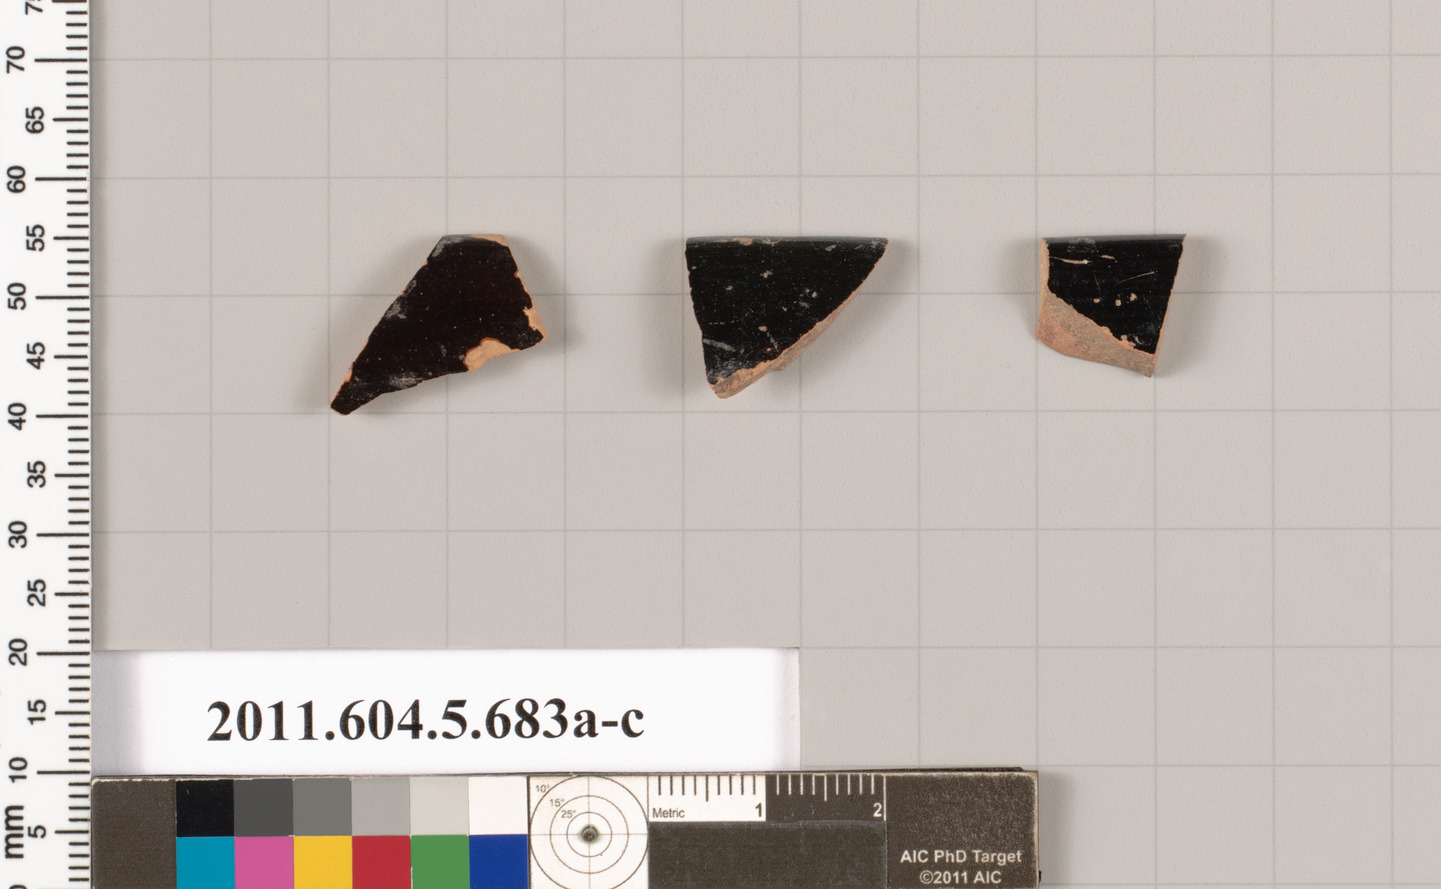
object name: kylix fragment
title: Terracotta rim fragments of kylikes (drinking cups)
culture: greek, attic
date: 600-401 BCE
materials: terracotta